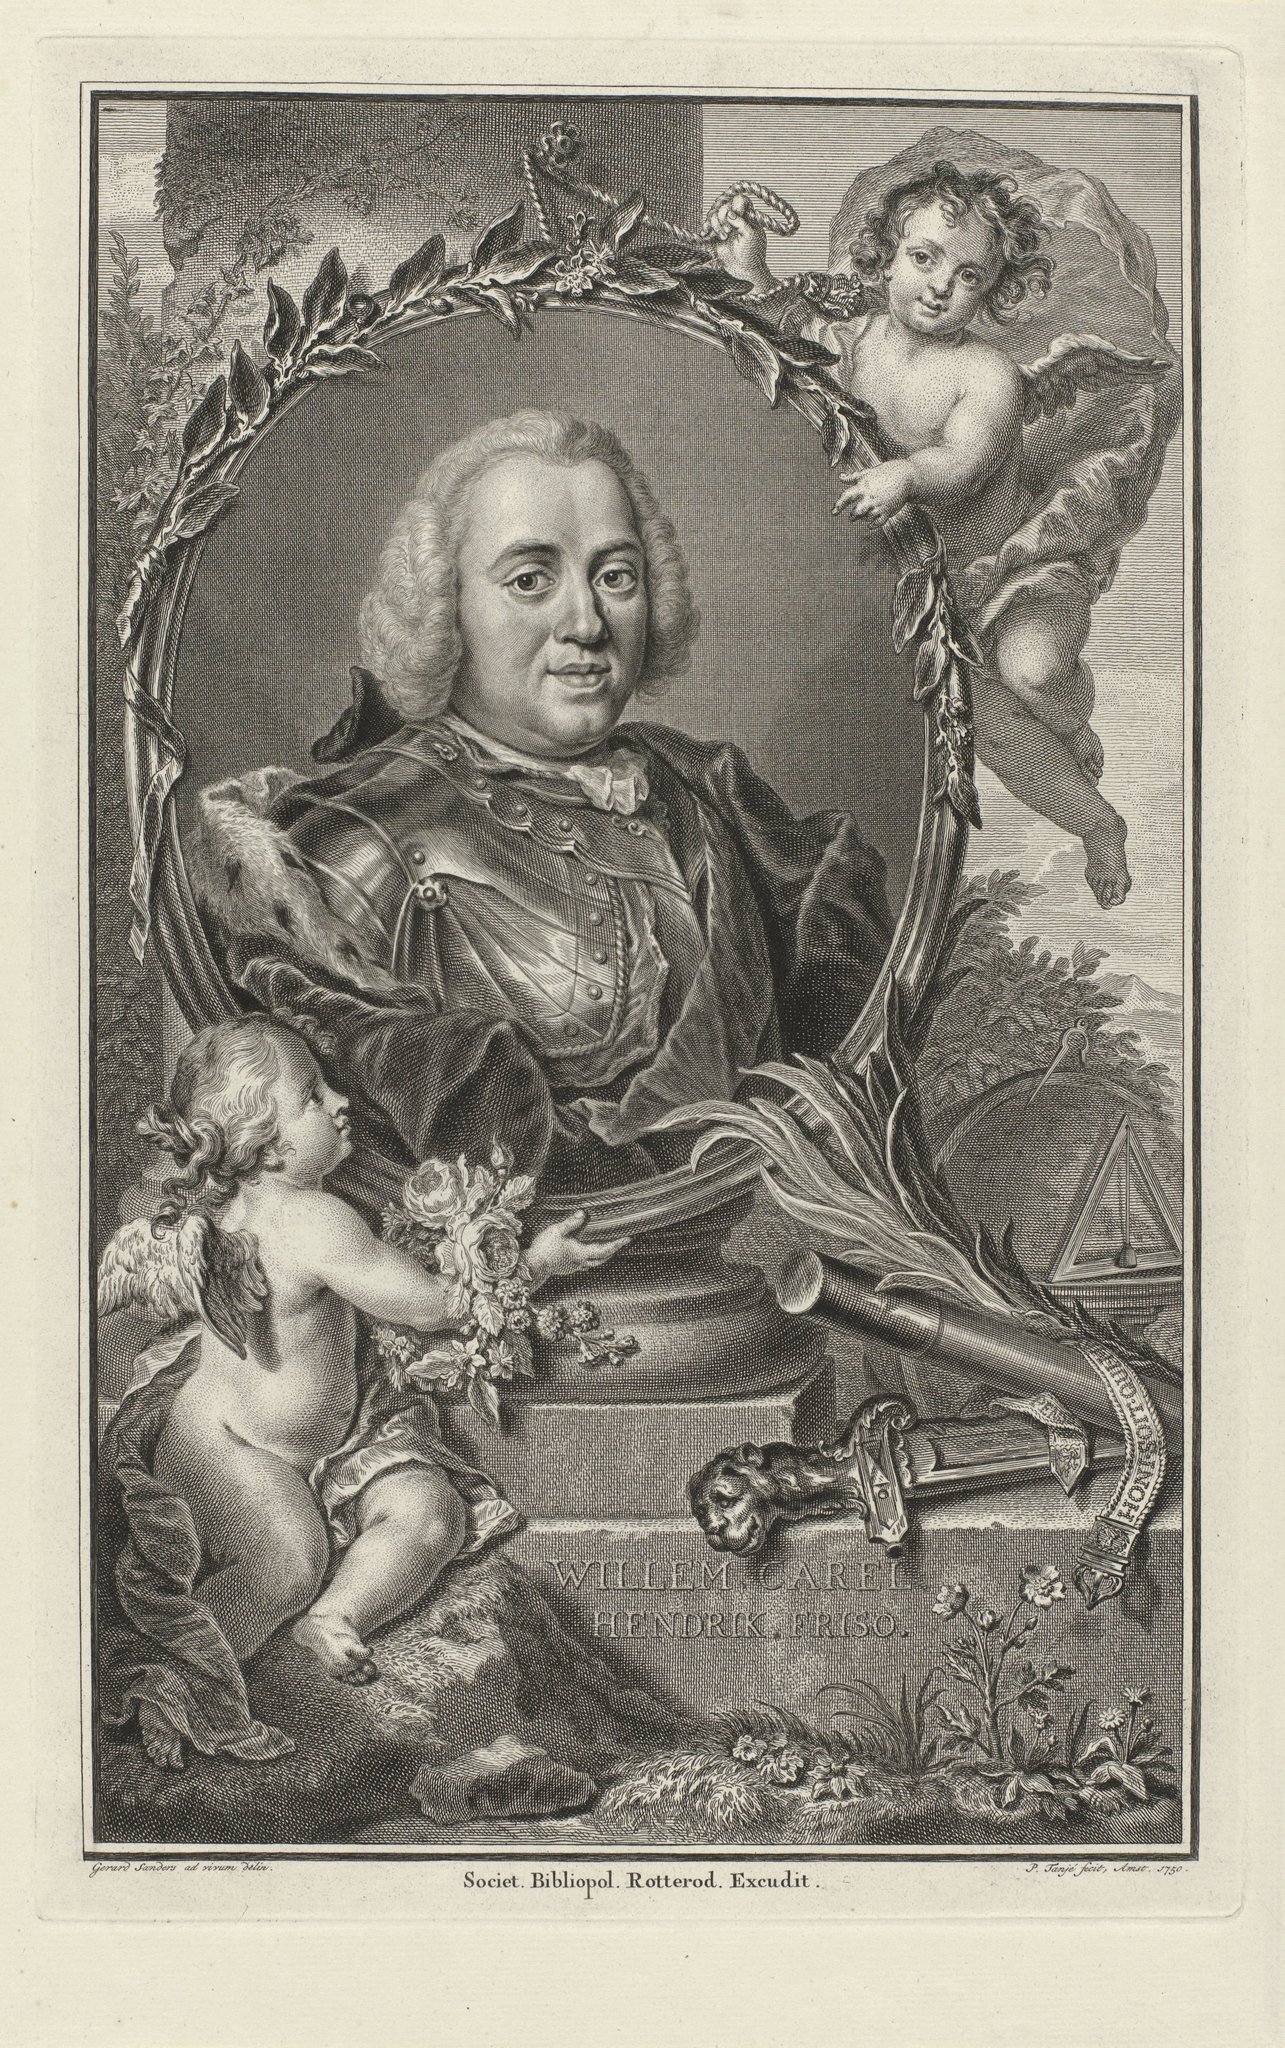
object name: print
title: Portret van Willem IV, prins van Oranje-Nassau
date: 1750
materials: paper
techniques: engraving, etching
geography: amsterdam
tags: willem iv (prins van oranje-nassau), knighthood order (garter) - insignia of a knighthood order, e.g.: badge, chain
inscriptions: date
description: Portret van Willem IV in een ovaal met eikenloof, vastgehouden door twee putti. Daar omheen een aantal allegorische objecten, waaronder een commandostaf. Op een voetstuk zijn naam.